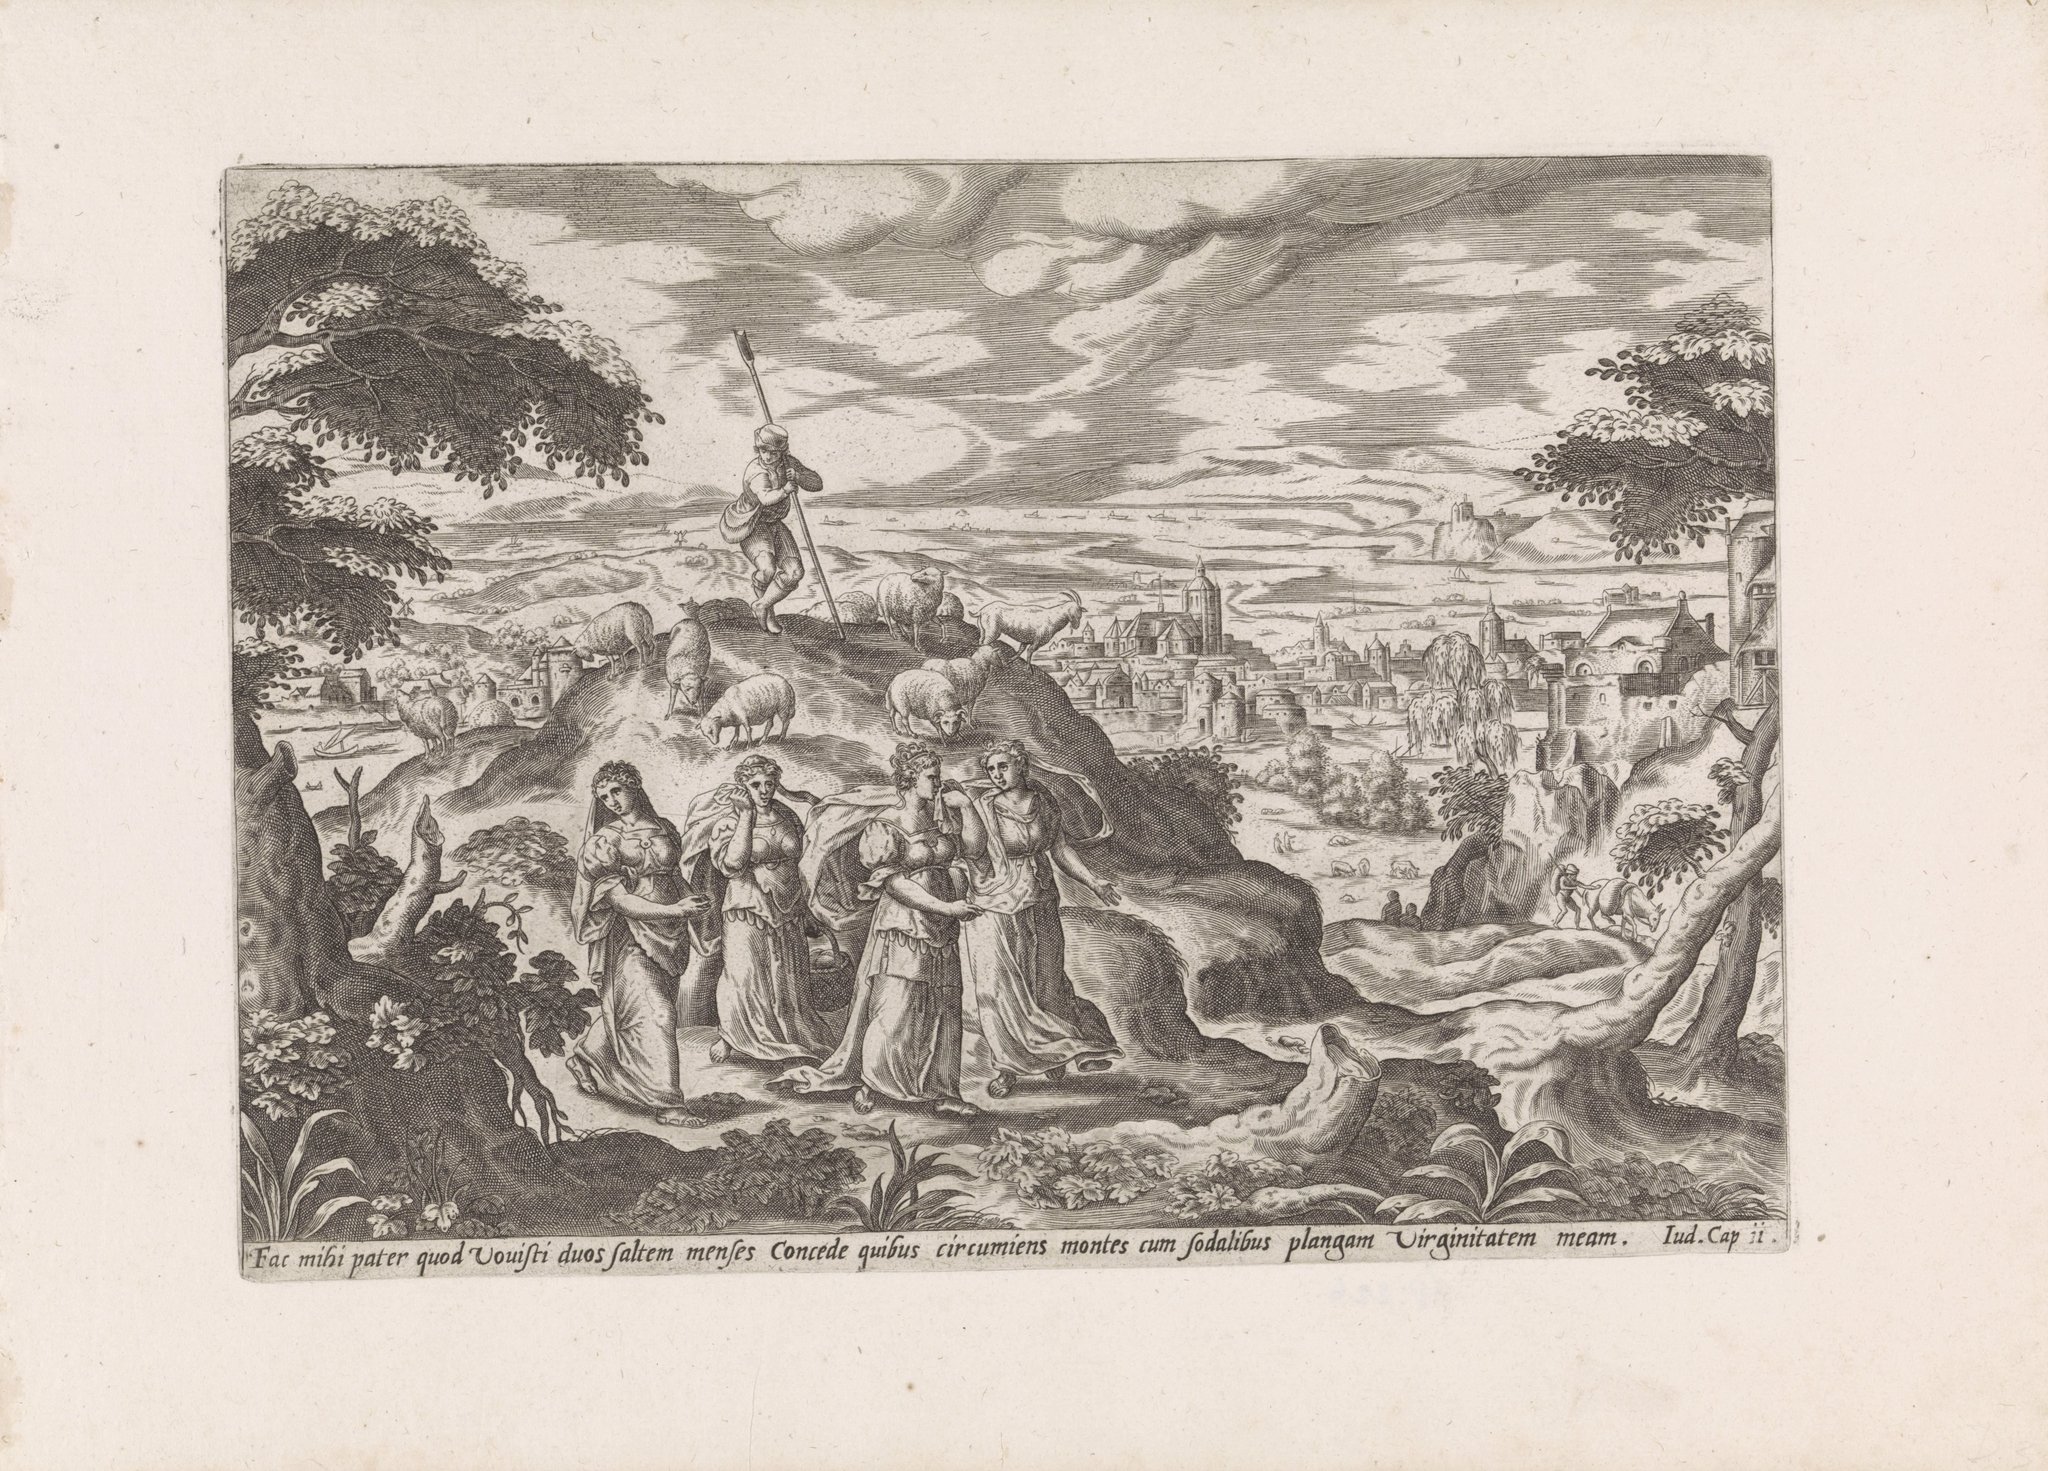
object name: print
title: Jefta's dochter treurt met haar vriendinnen in de bergen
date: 1579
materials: paper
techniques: engraving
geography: antwerp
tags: jephthah's daughter retreats to the mountains with her companions to bewail her virginity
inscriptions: collector's mark: Lugt 2228, collector's mark: Lugt 2760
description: Jefta´s dochter trekt zich terug in de bergen om met haar vriendinnen om haar maagdelijkheid te treuren. Achter hen staat een herder met zijn schapen op een berg. Op de achtergrond een stad. Onder de voorstelling een verwijzing in het Latijn naar de Bijbeltekst in Ri. 11.